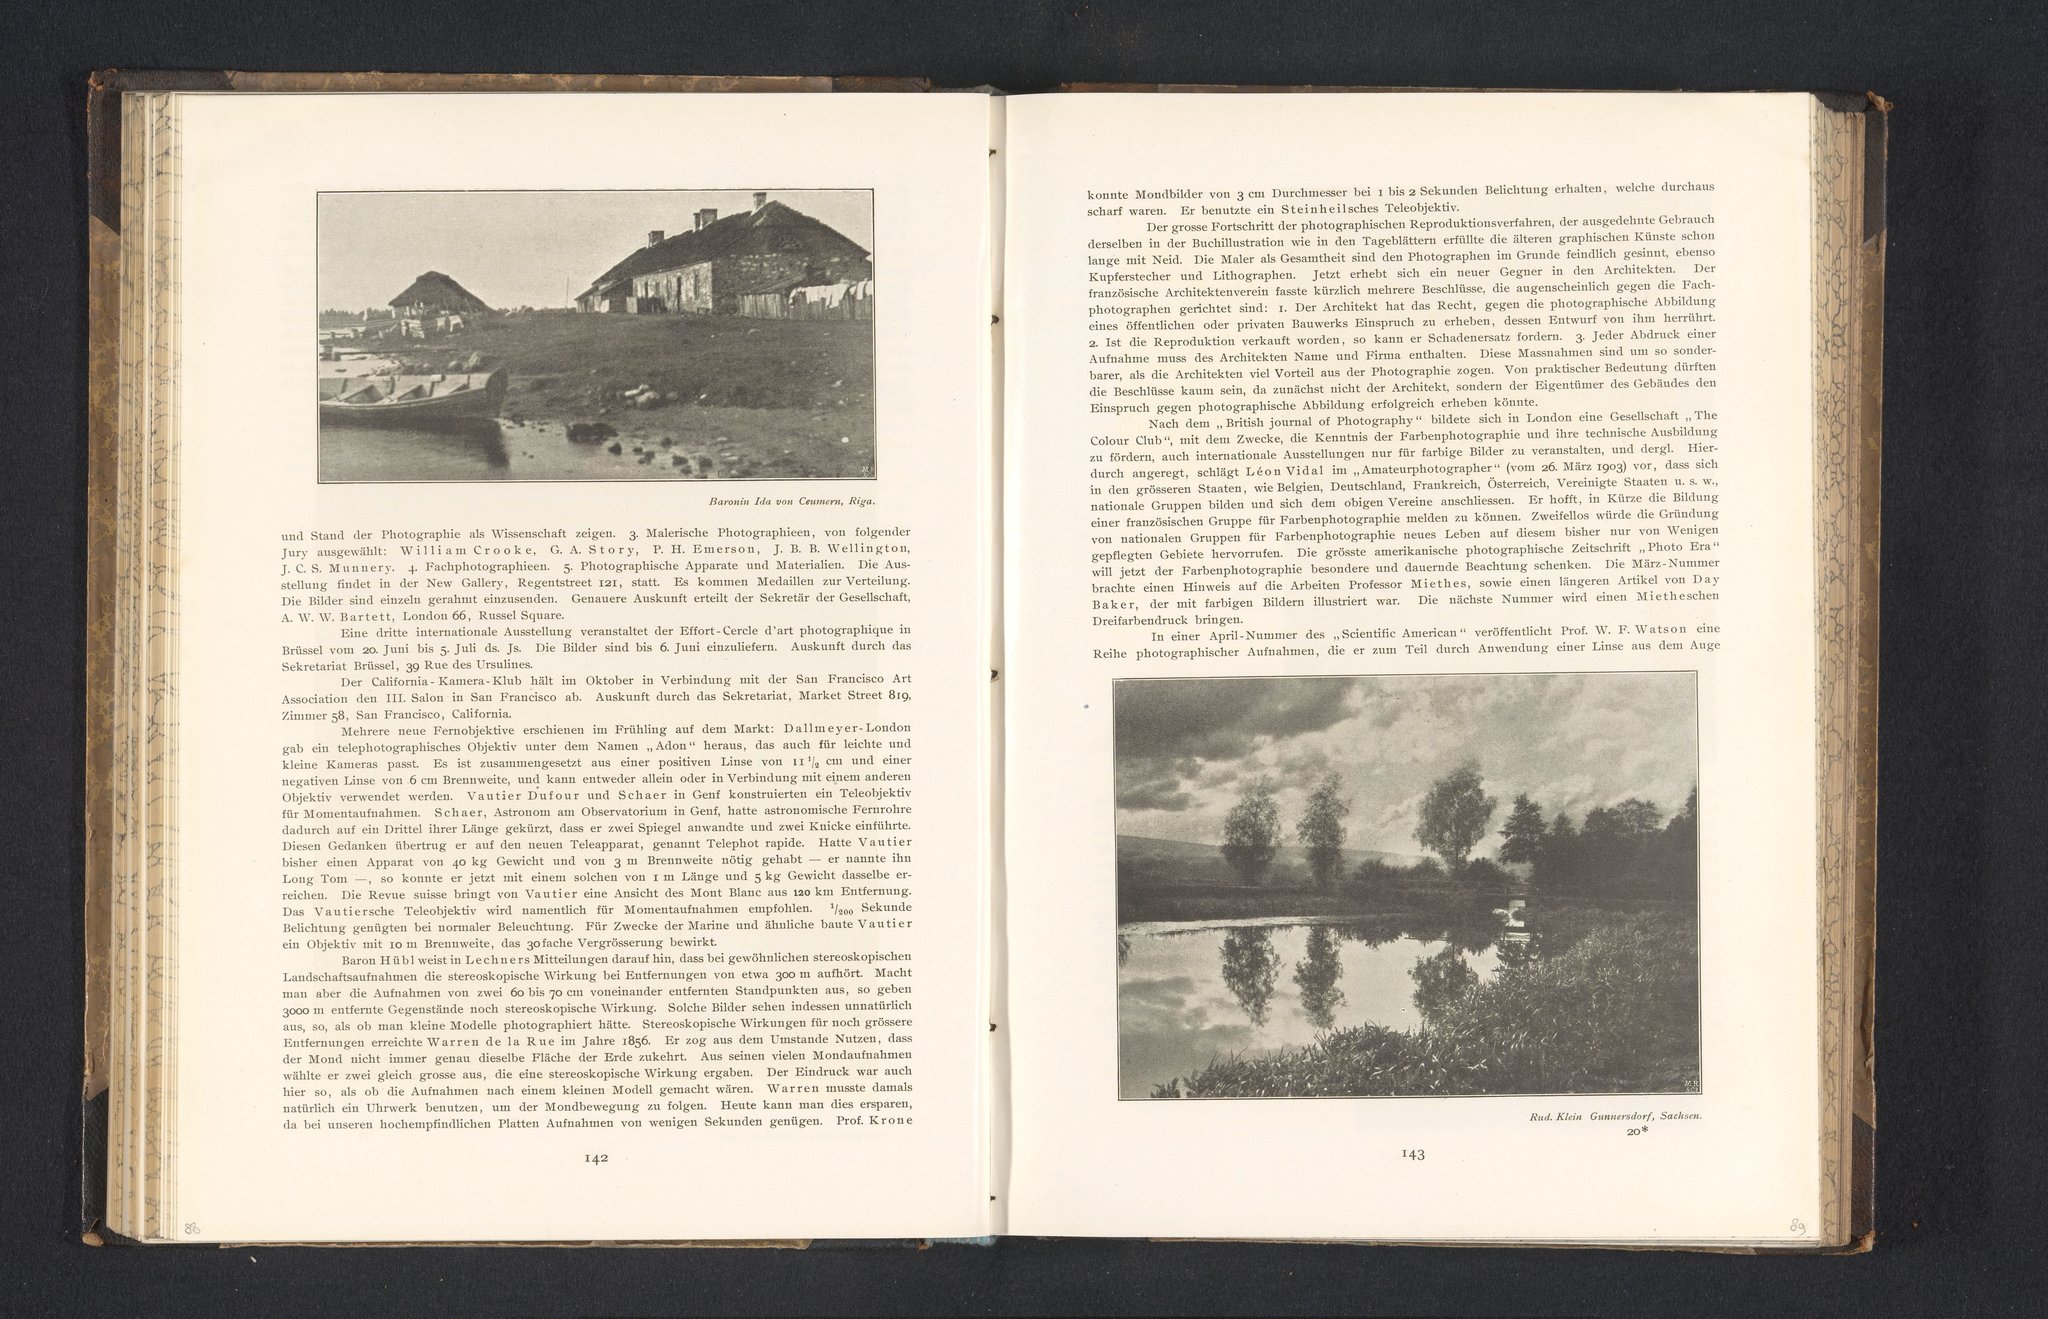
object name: photomechanical print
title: Landschap met een waterweg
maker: rud. klein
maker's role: fotograaf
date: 1898-1903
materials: paper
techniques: autotype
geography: berlin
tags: landscapes with waters, waterscapes, seascapes (in the temperate zone)